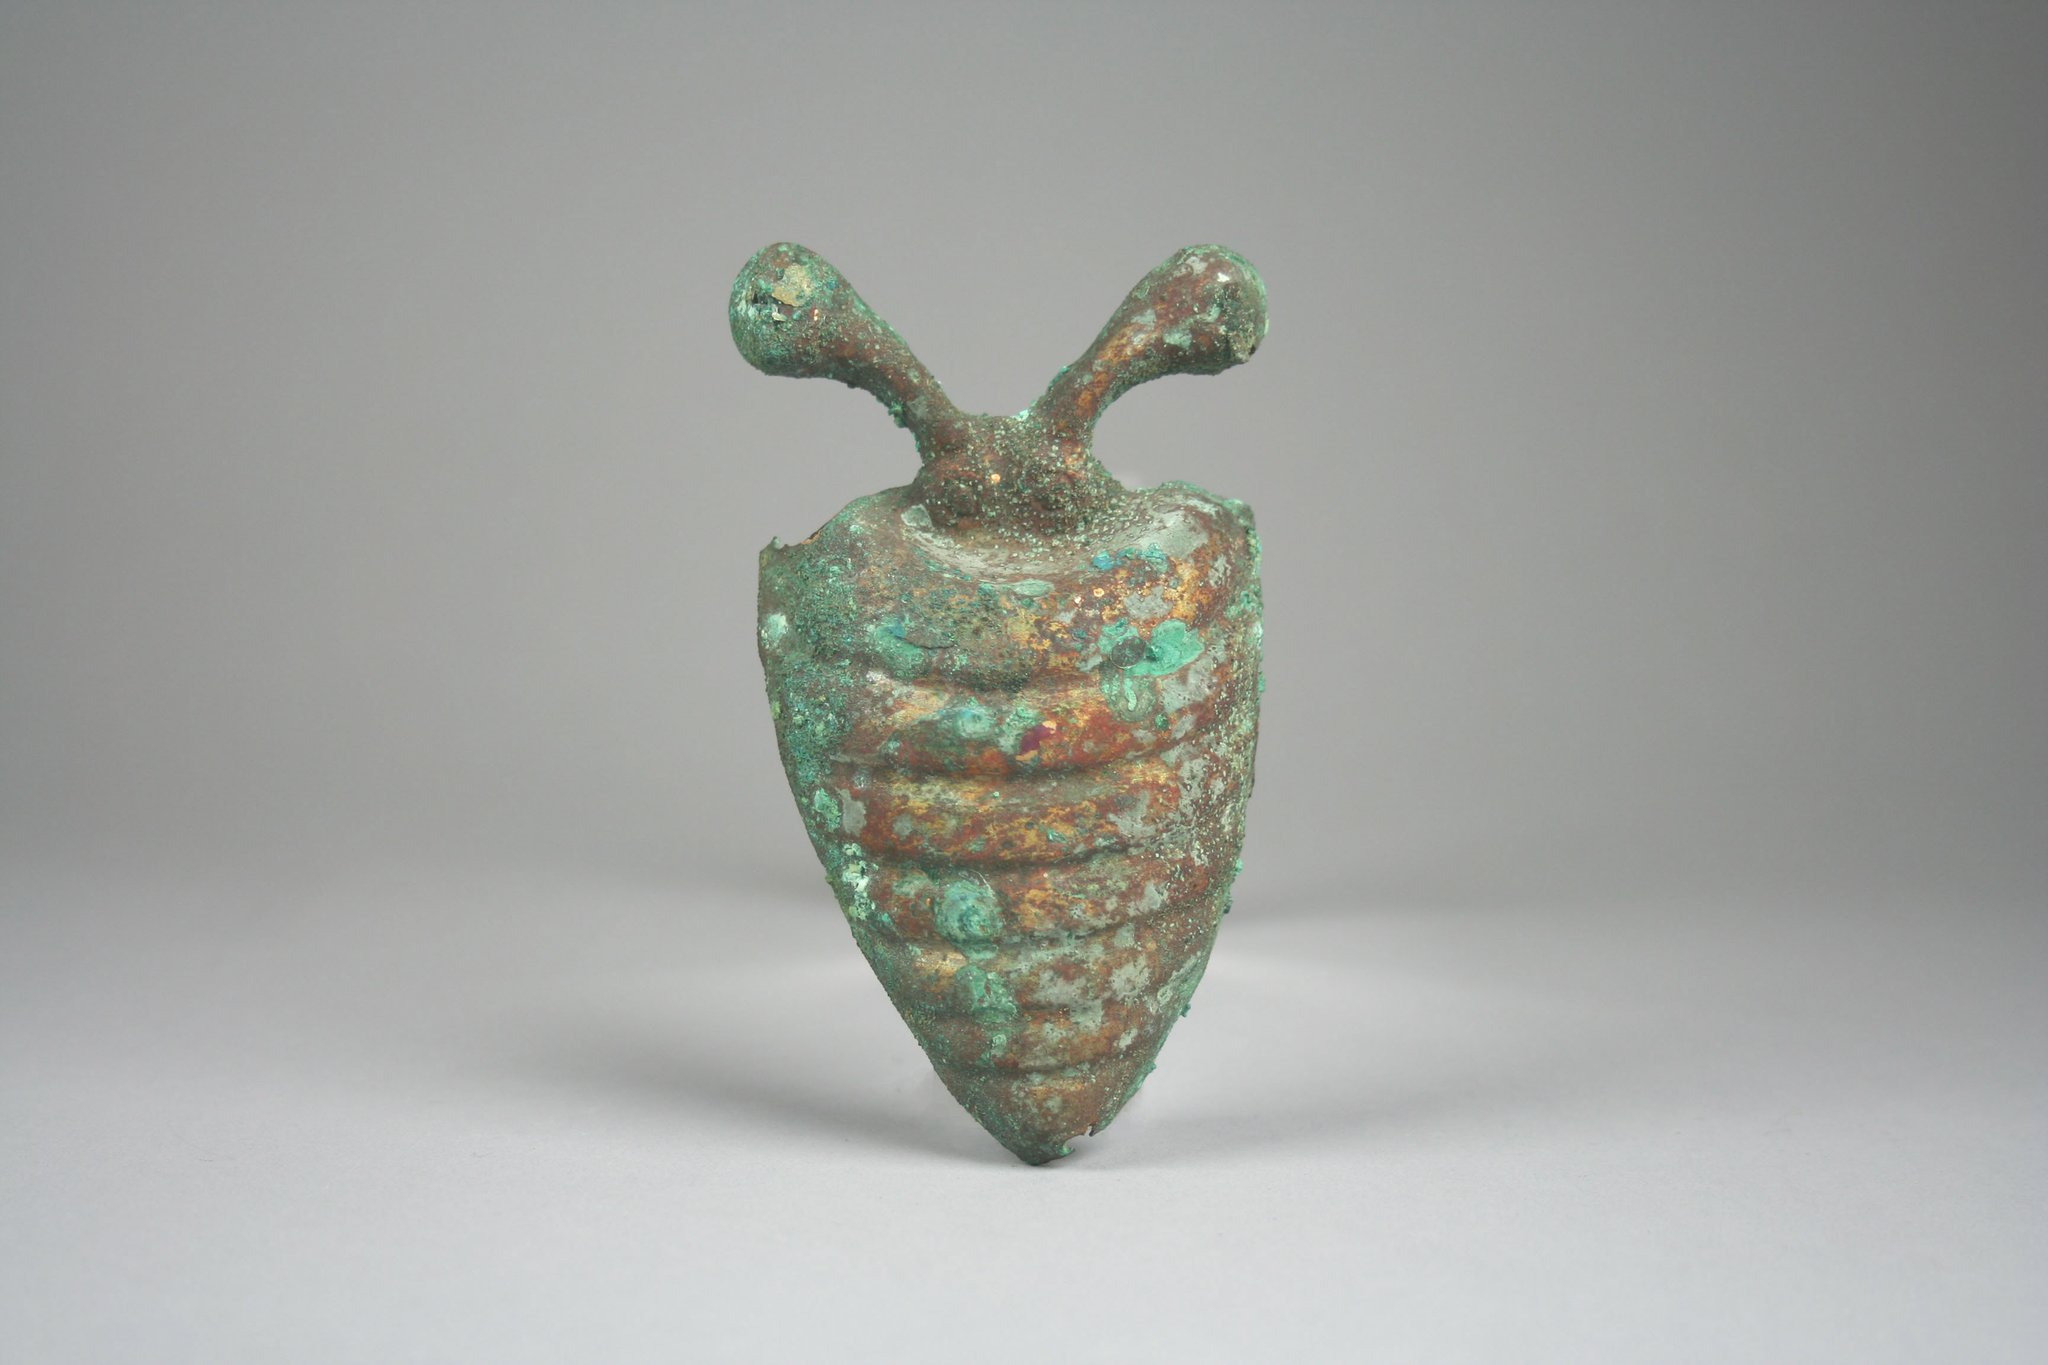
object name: ornament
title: Animal Ornament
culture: moche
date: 501-700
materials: gilt copper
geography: peru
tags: insects